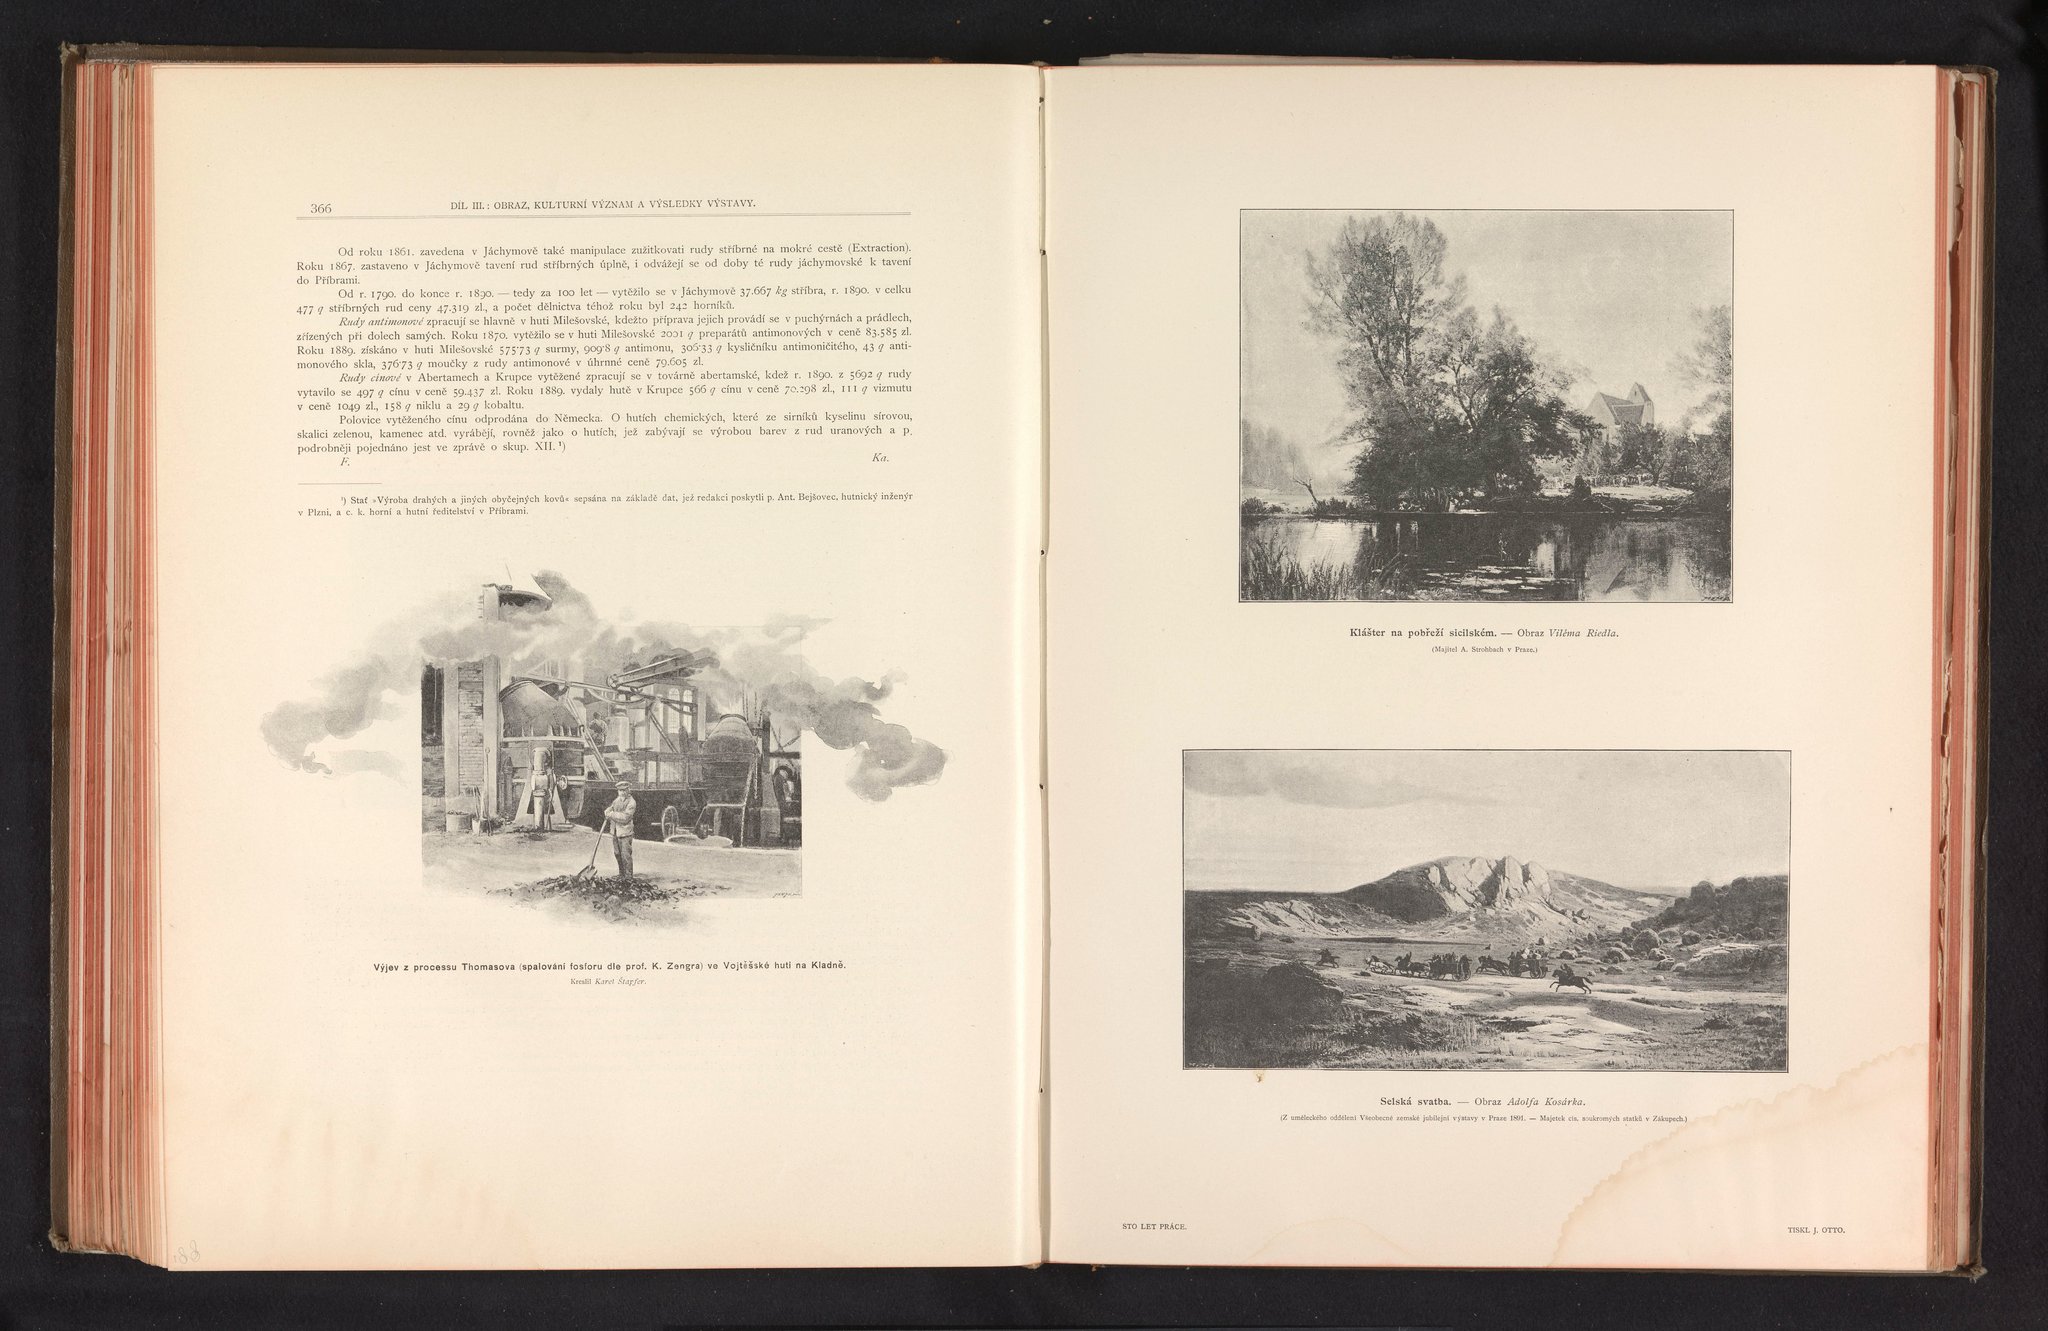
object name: photomechanical print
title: Fotoreproductie van een tekening, voorstellende een arbeider voor een verbrandingsoven voor fosfor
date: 1890-1895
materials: paper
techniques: autotype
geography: prague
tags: blast-furnace, working class, labourers